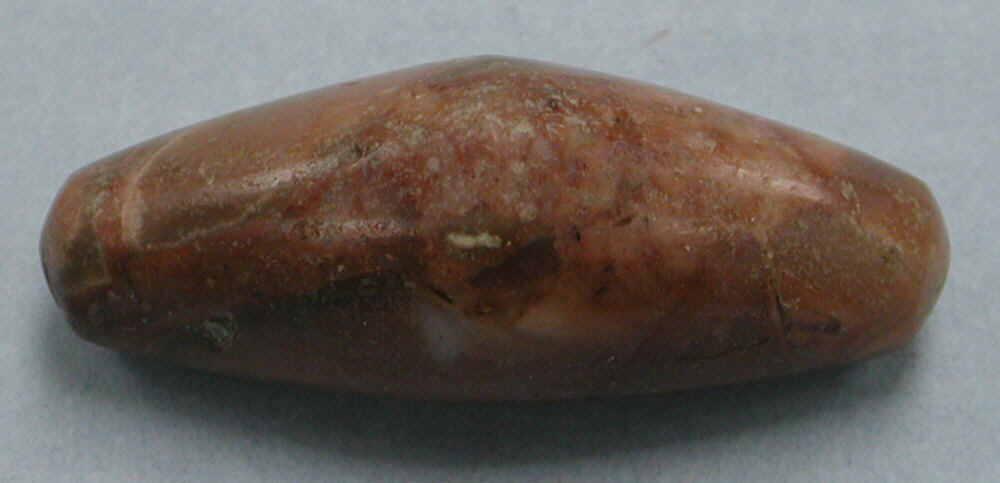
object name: ritual stone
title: Polishing Stone (pulidor)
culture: mexican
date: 1501-1600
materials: stone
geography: mexico